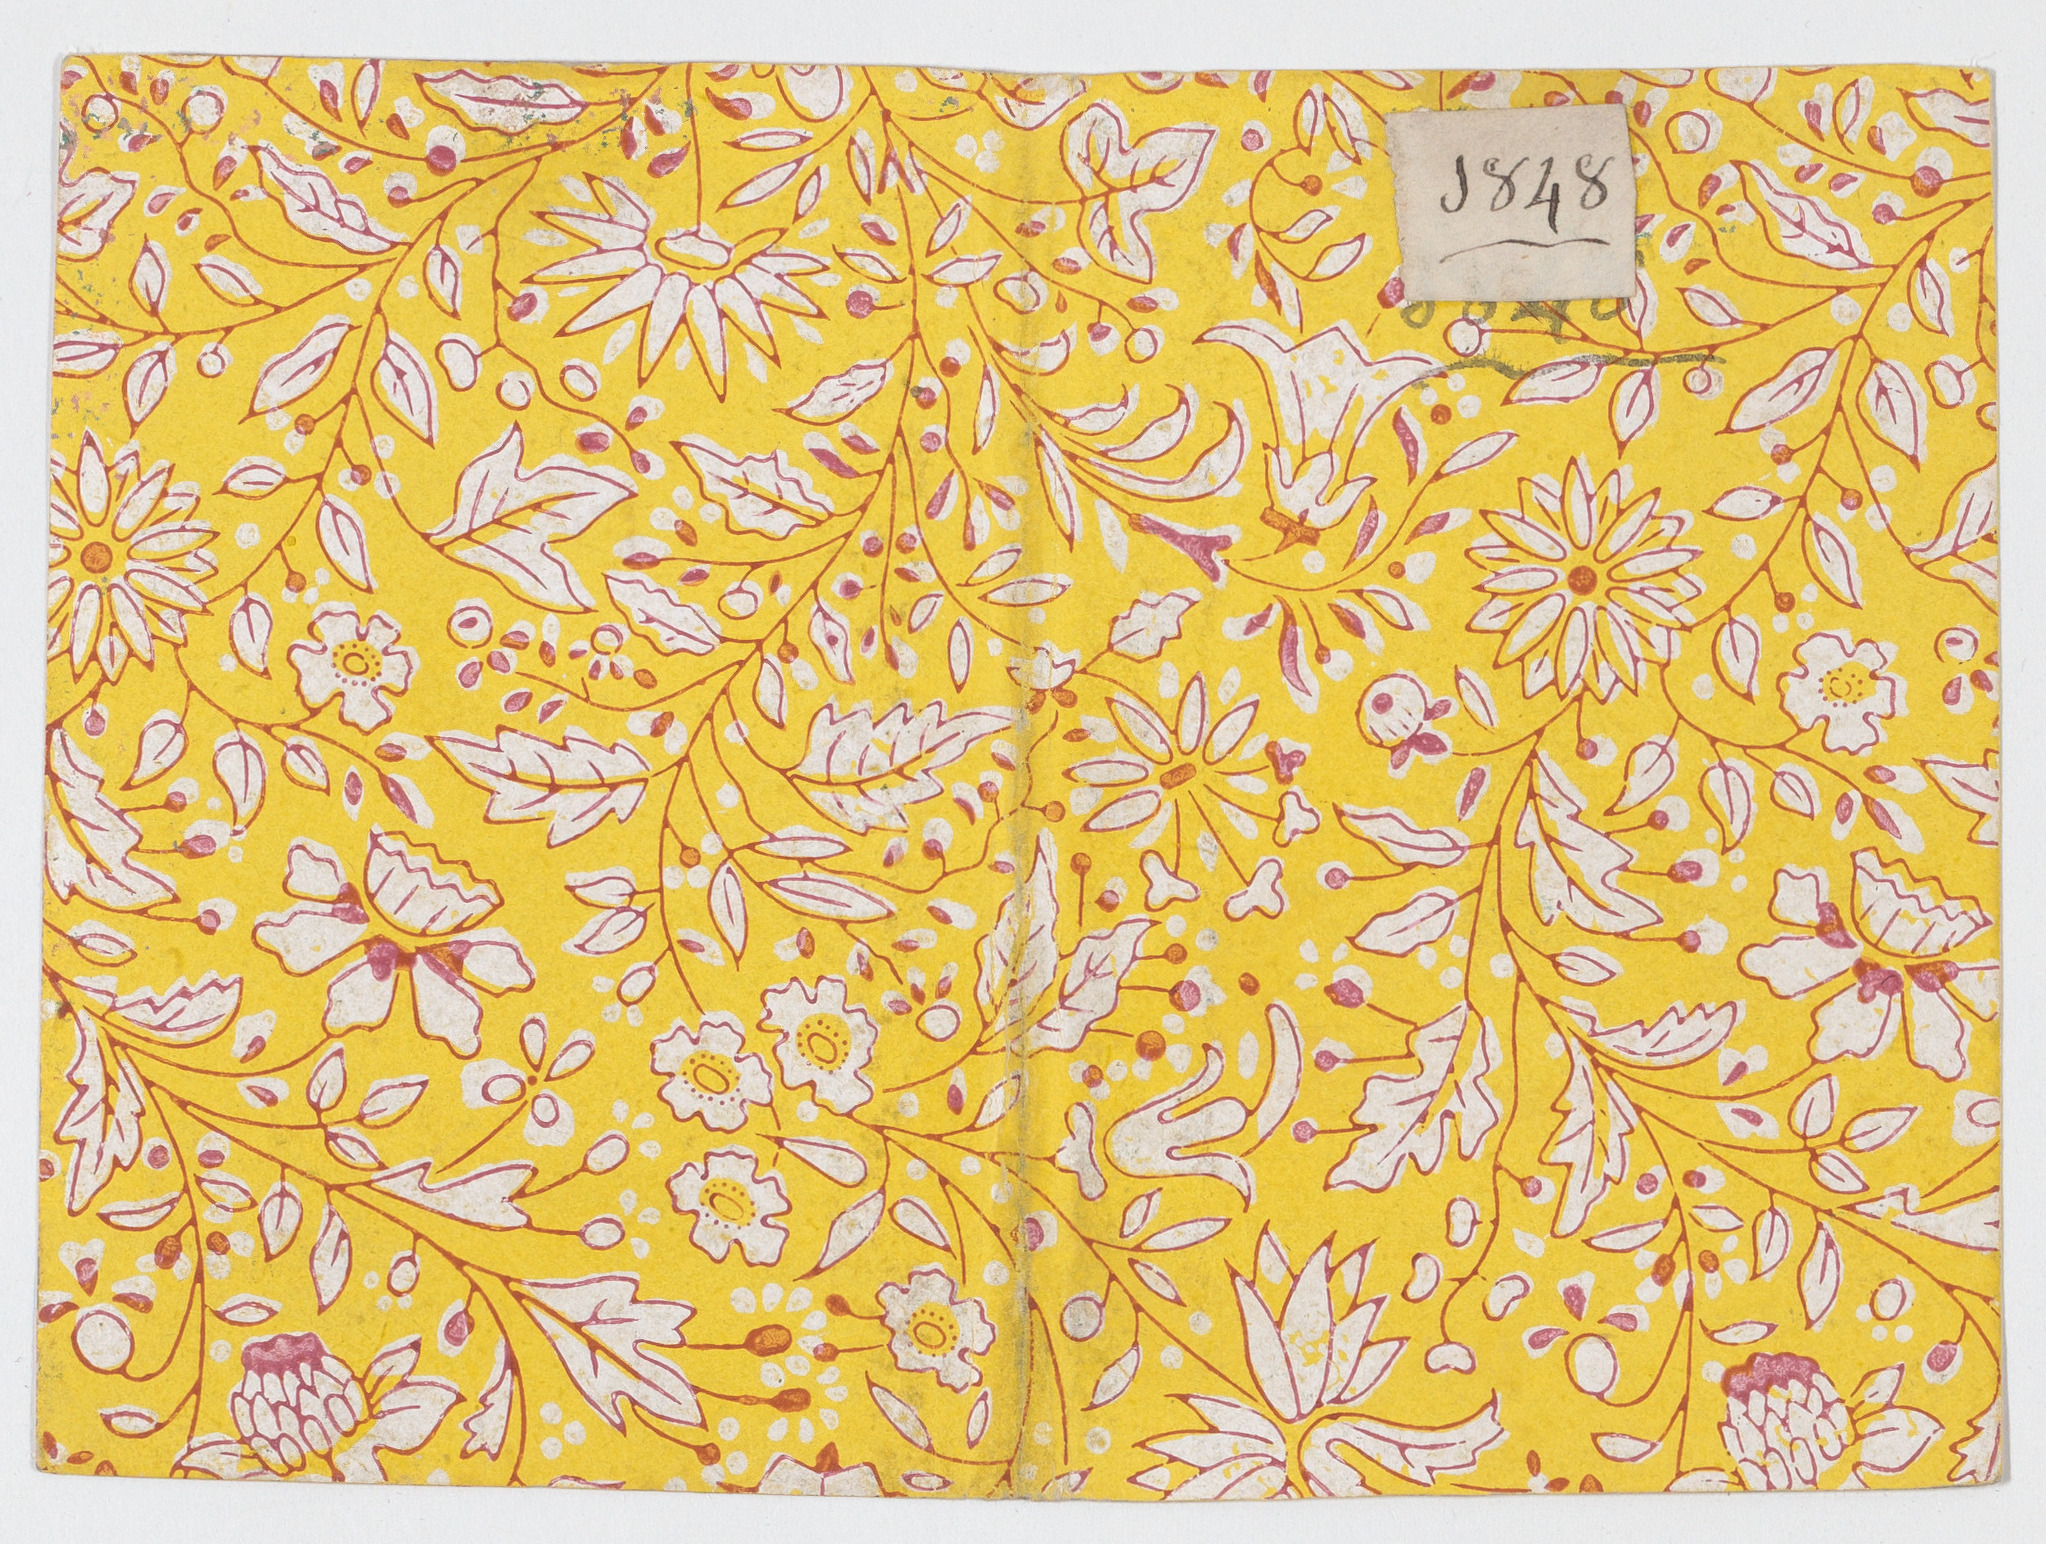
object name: print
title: Yellow book cover with floral and vine pattern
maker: Anonymous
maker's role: artist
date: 1848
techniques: relief print